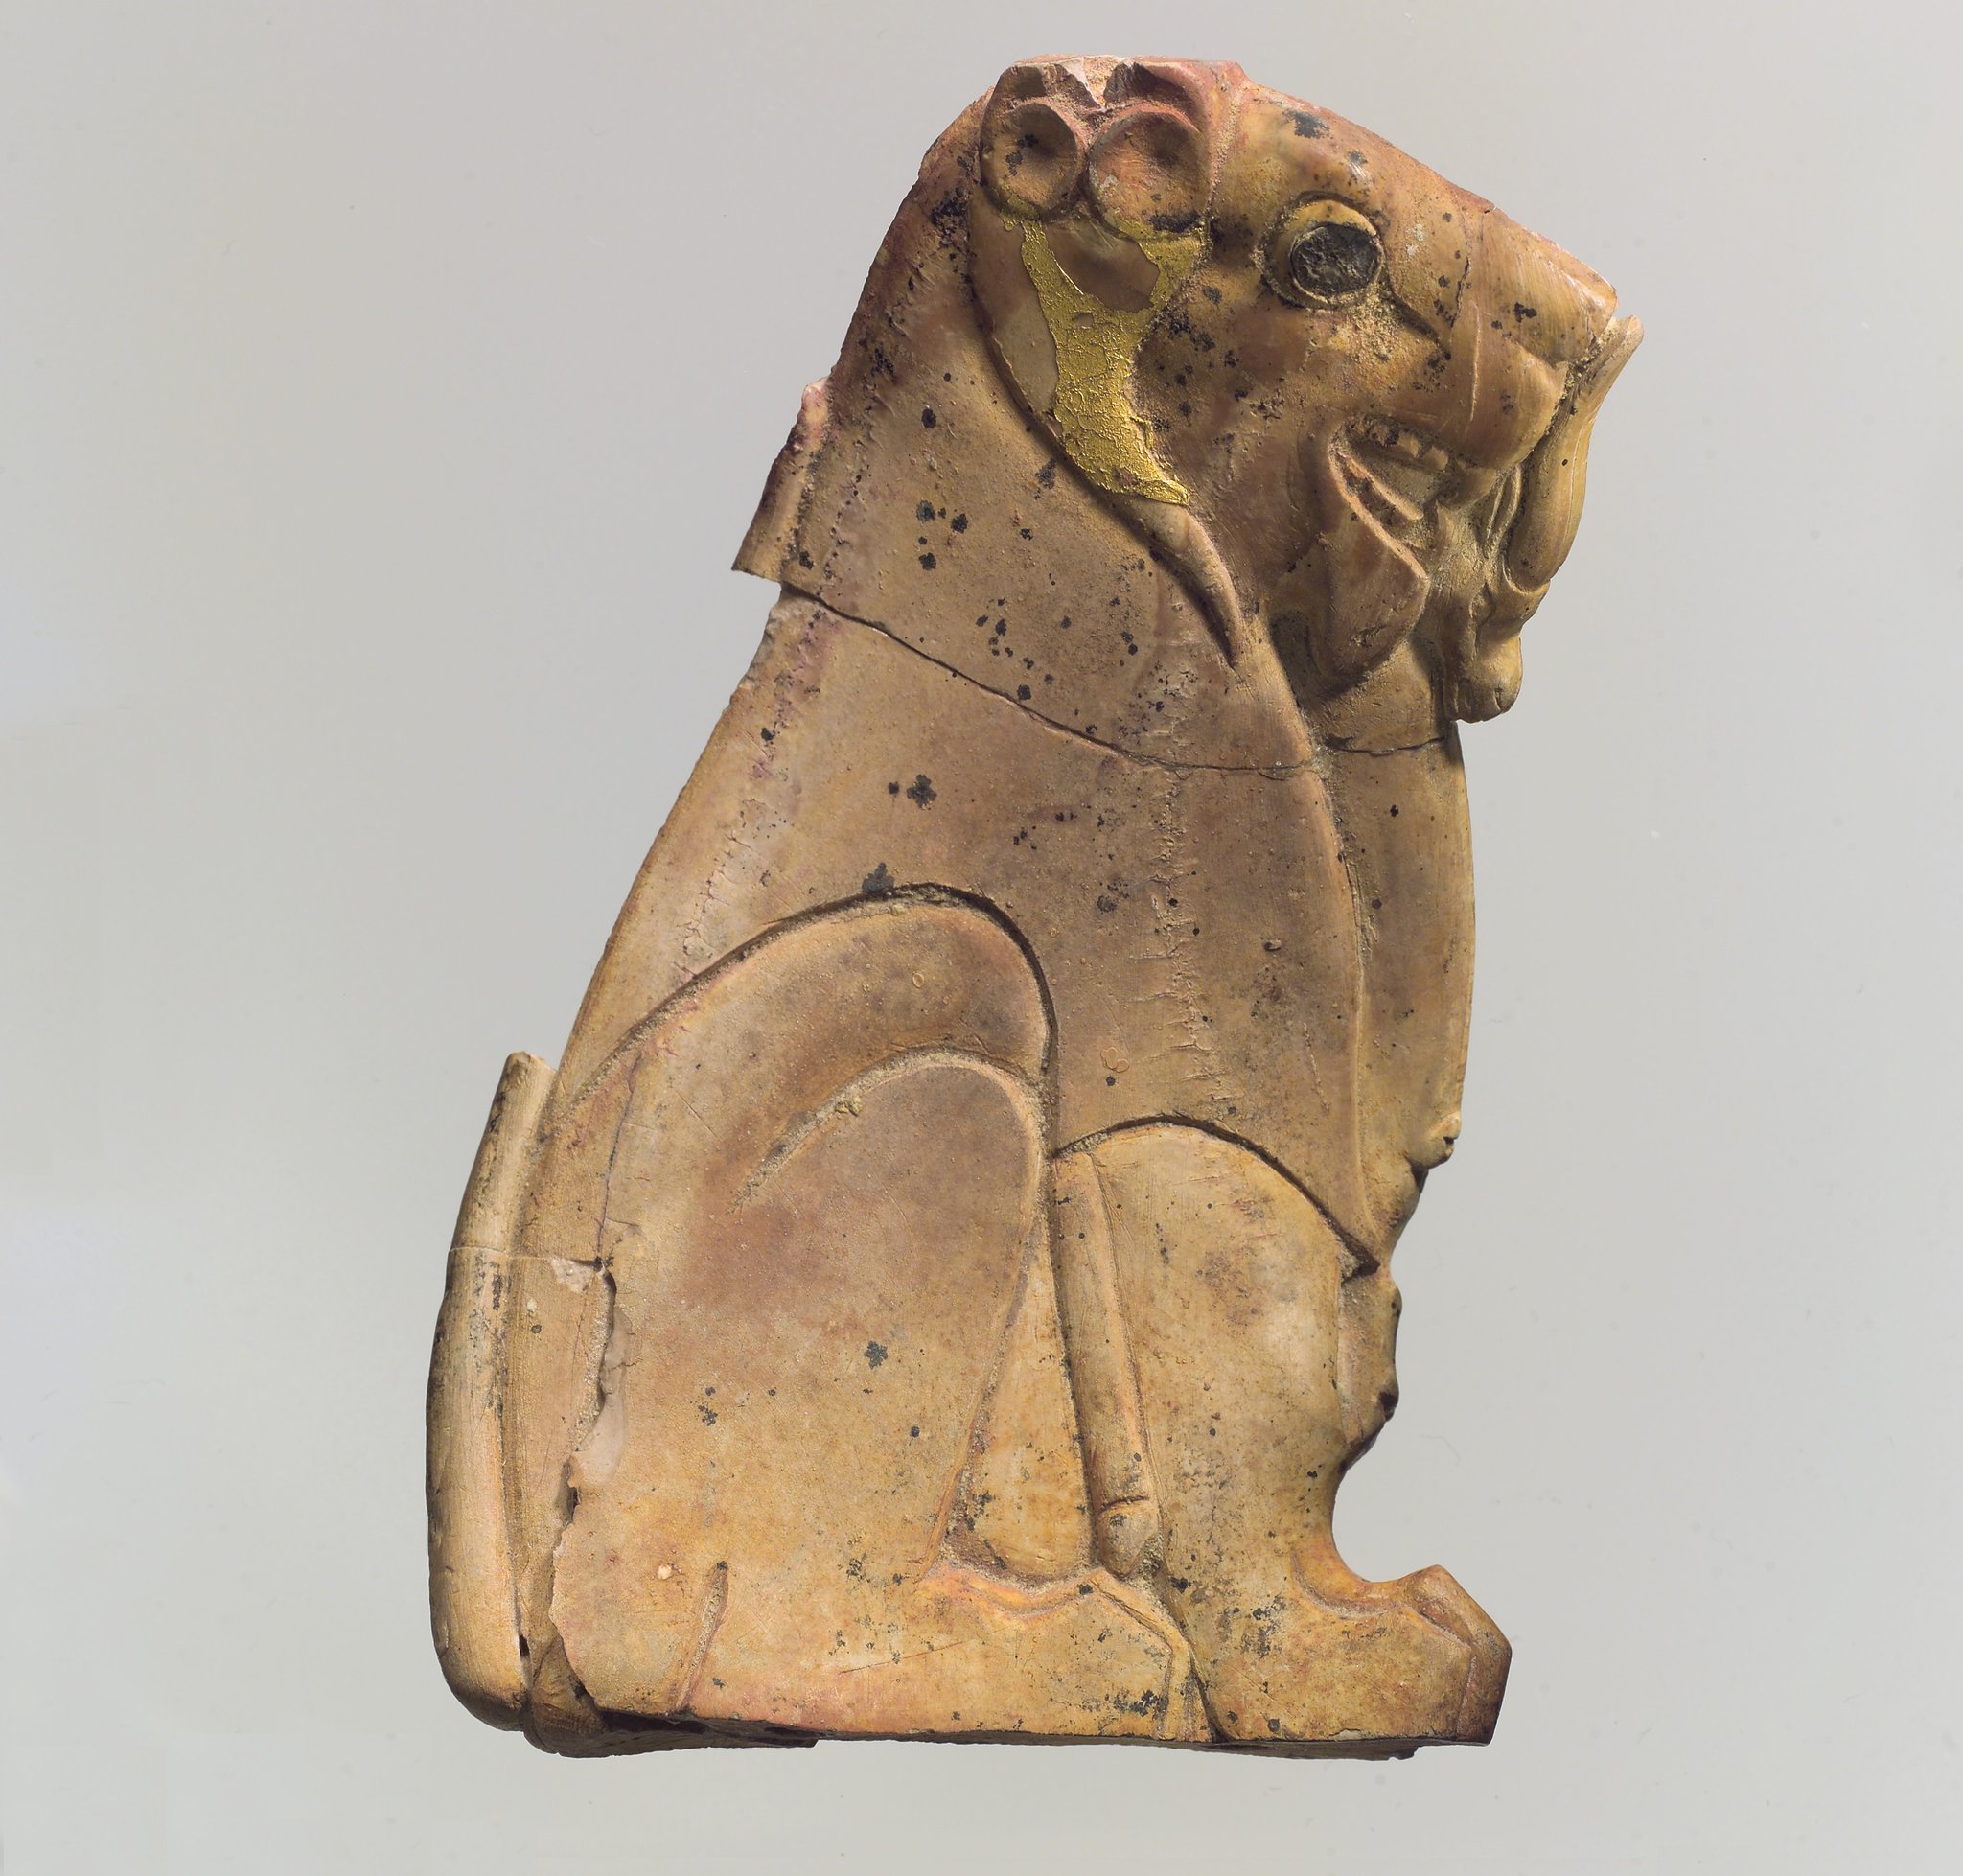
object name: furniture element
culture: assyrian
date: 1800-1701 BCE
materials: gold, ivory, paint, paste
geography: anatolia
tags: animals